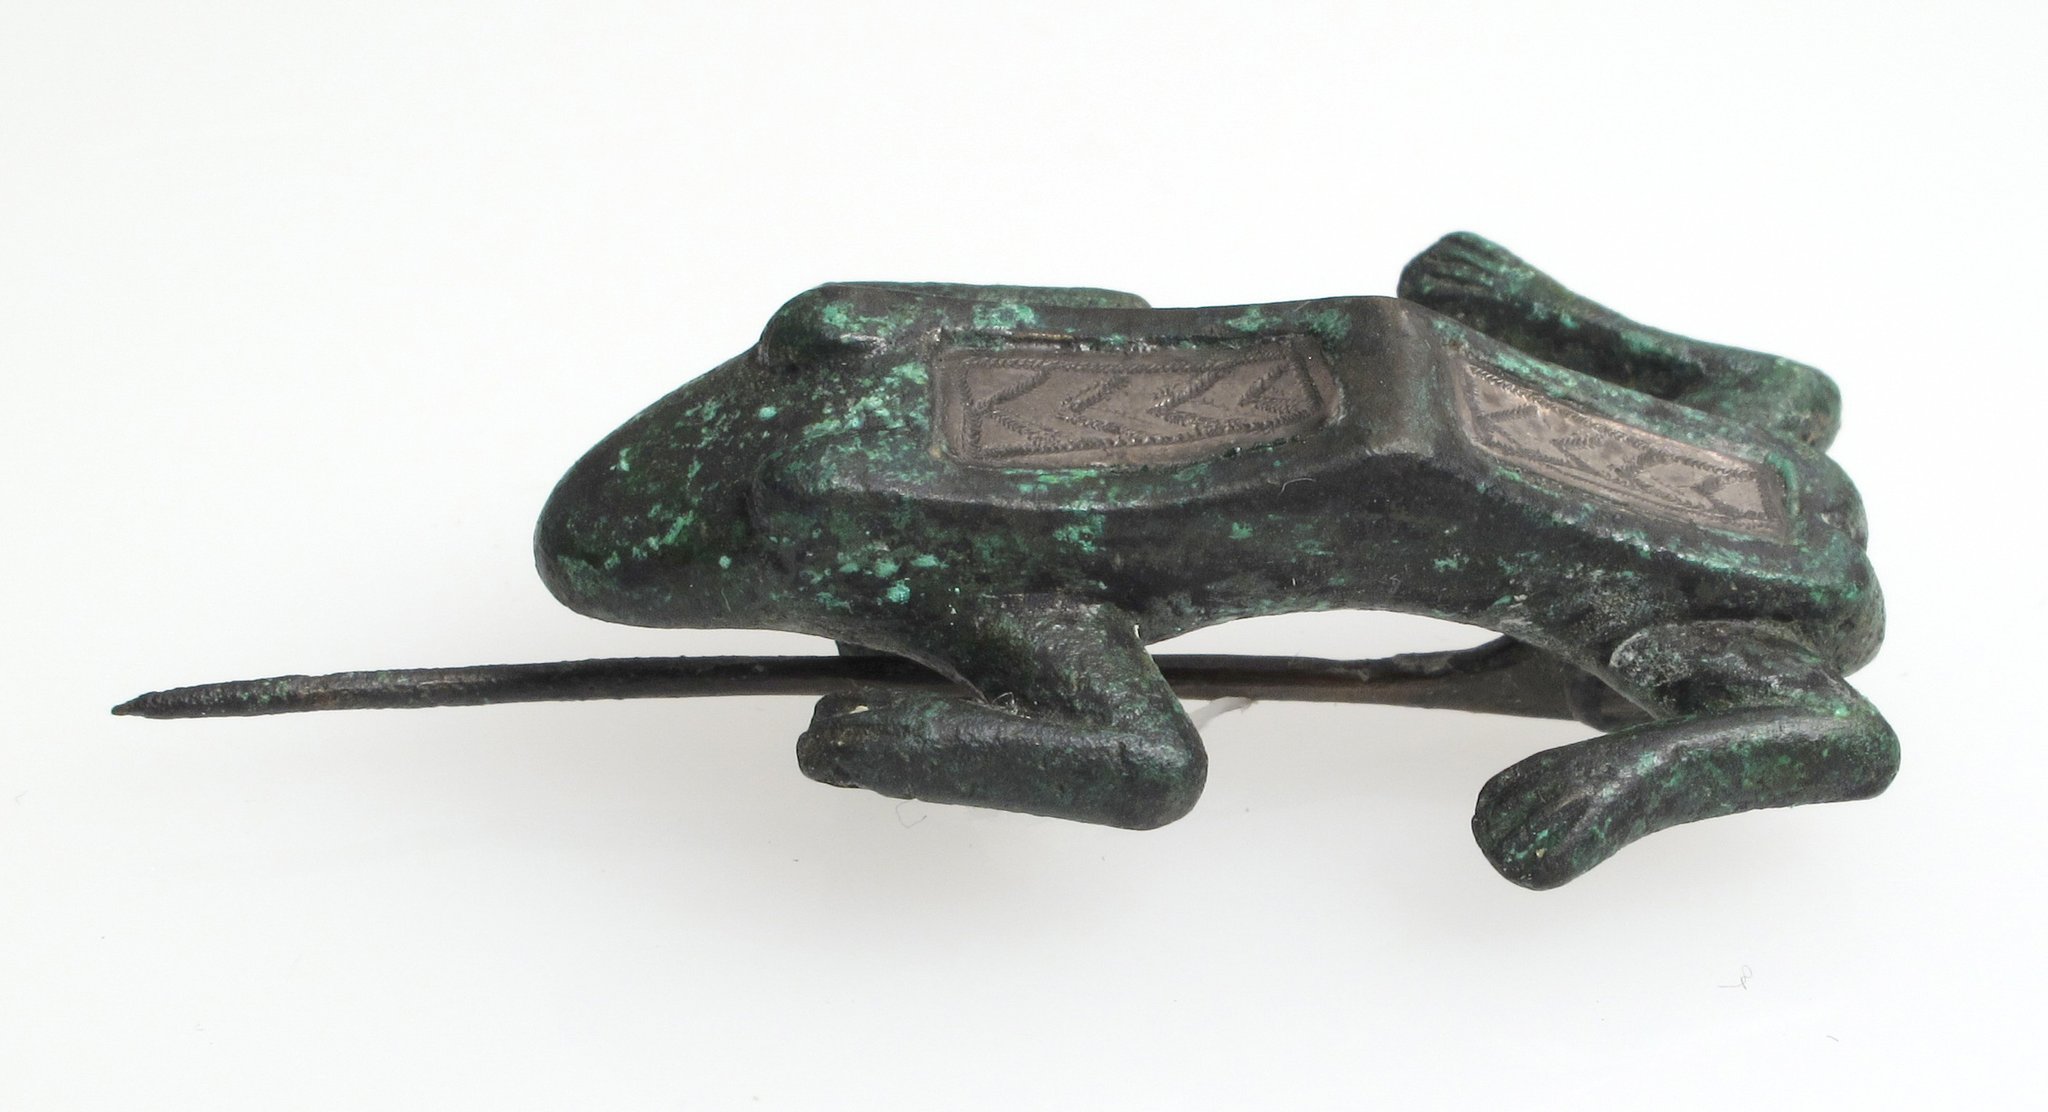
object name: brooch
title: Animal-Shaped Brooch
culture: roman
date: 101-400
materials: bronze, silver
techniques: inlay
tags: frogs